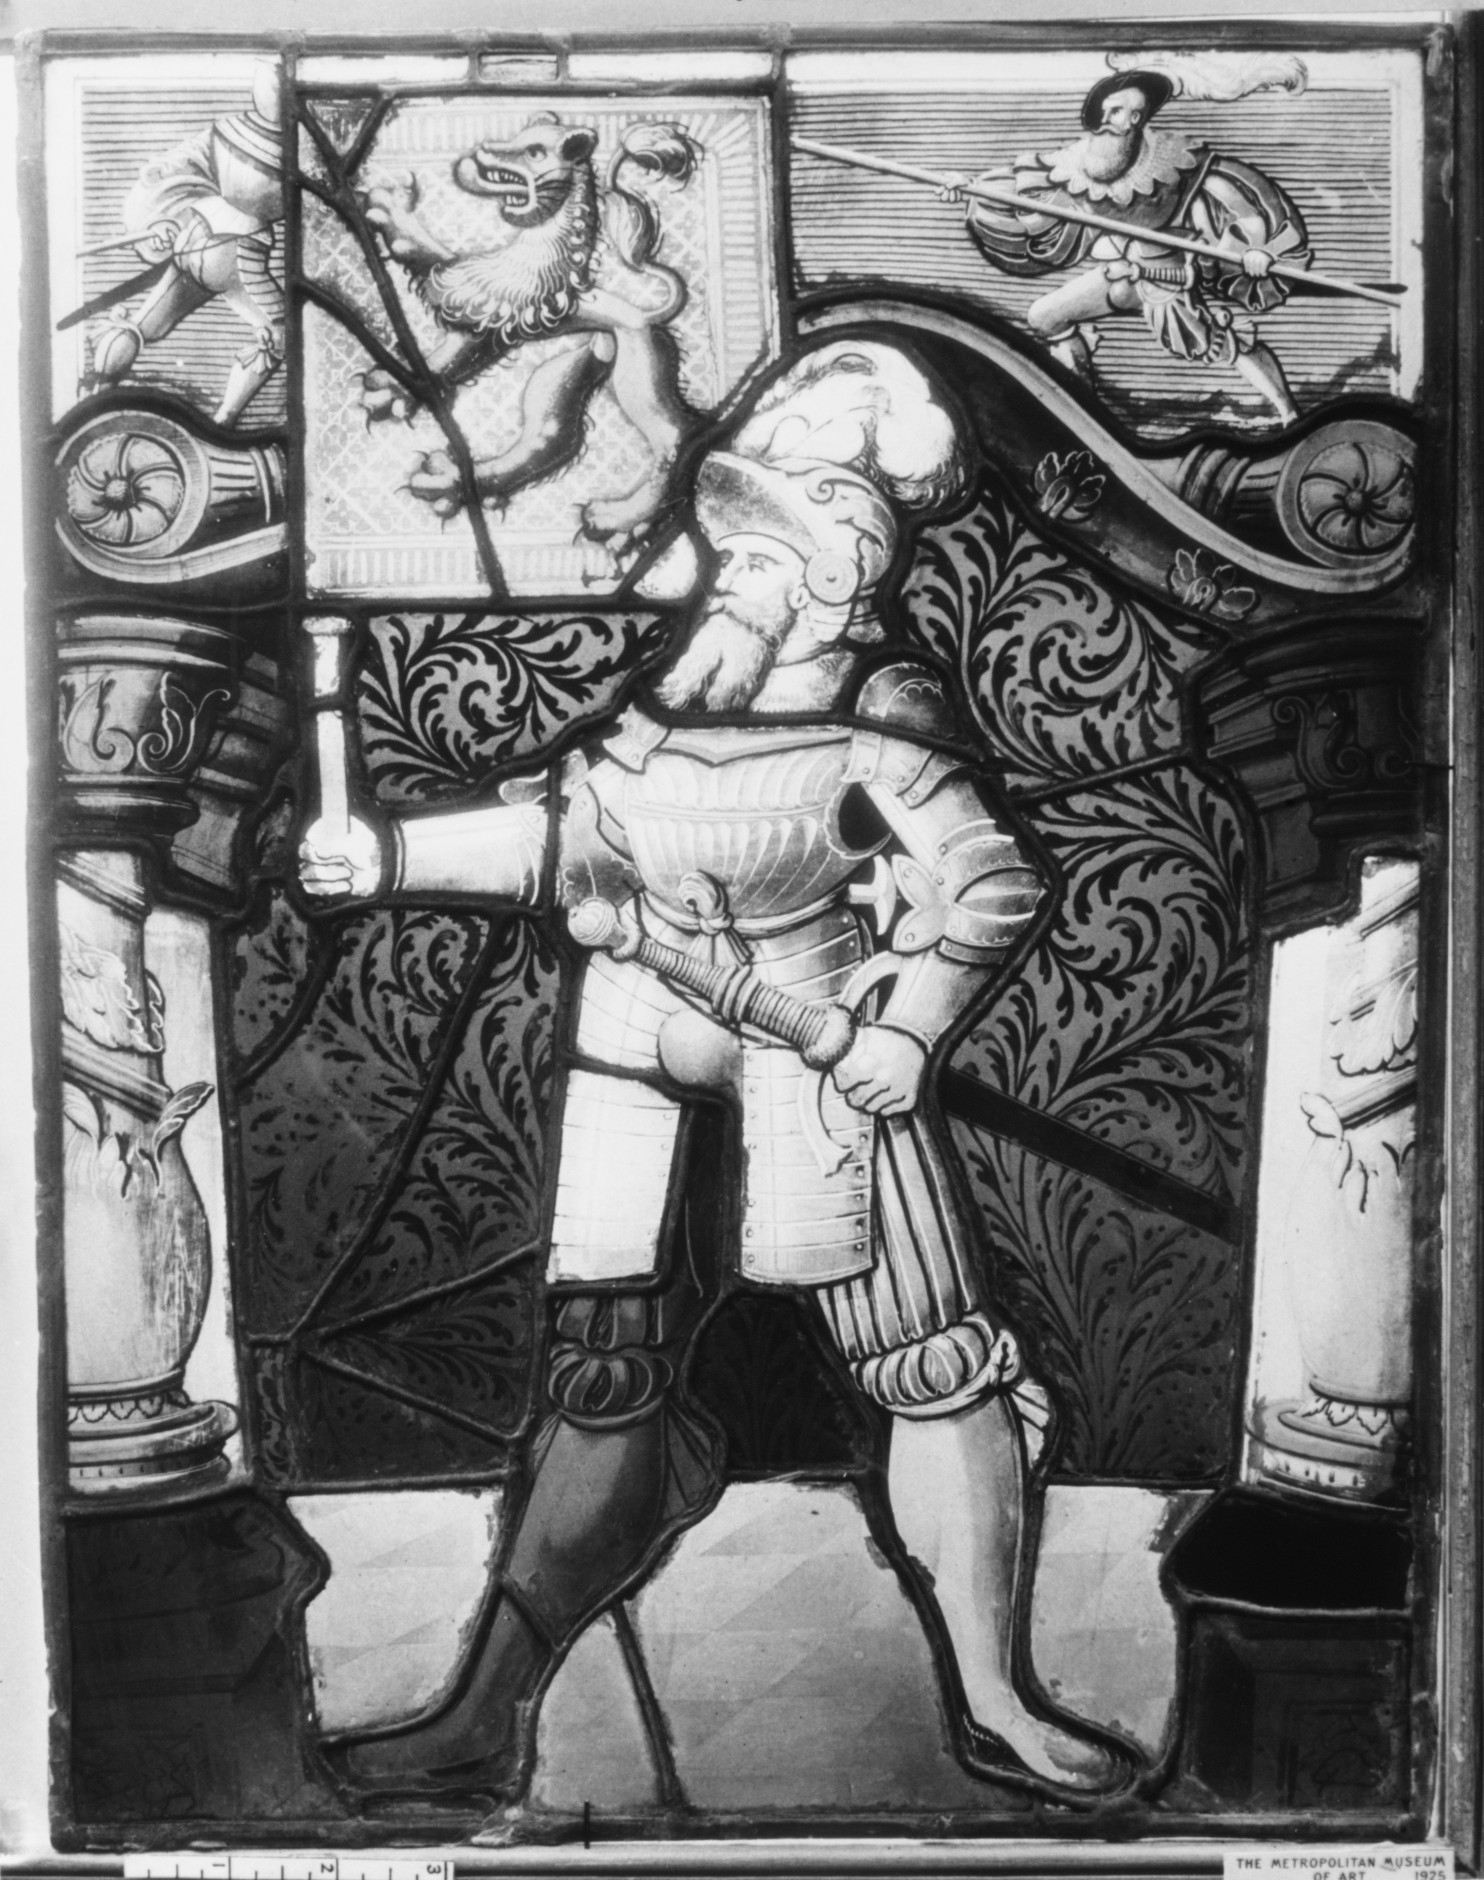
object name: panel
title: Ensign with flag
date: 1560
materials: glass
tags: animals,soldiers,swords,flags